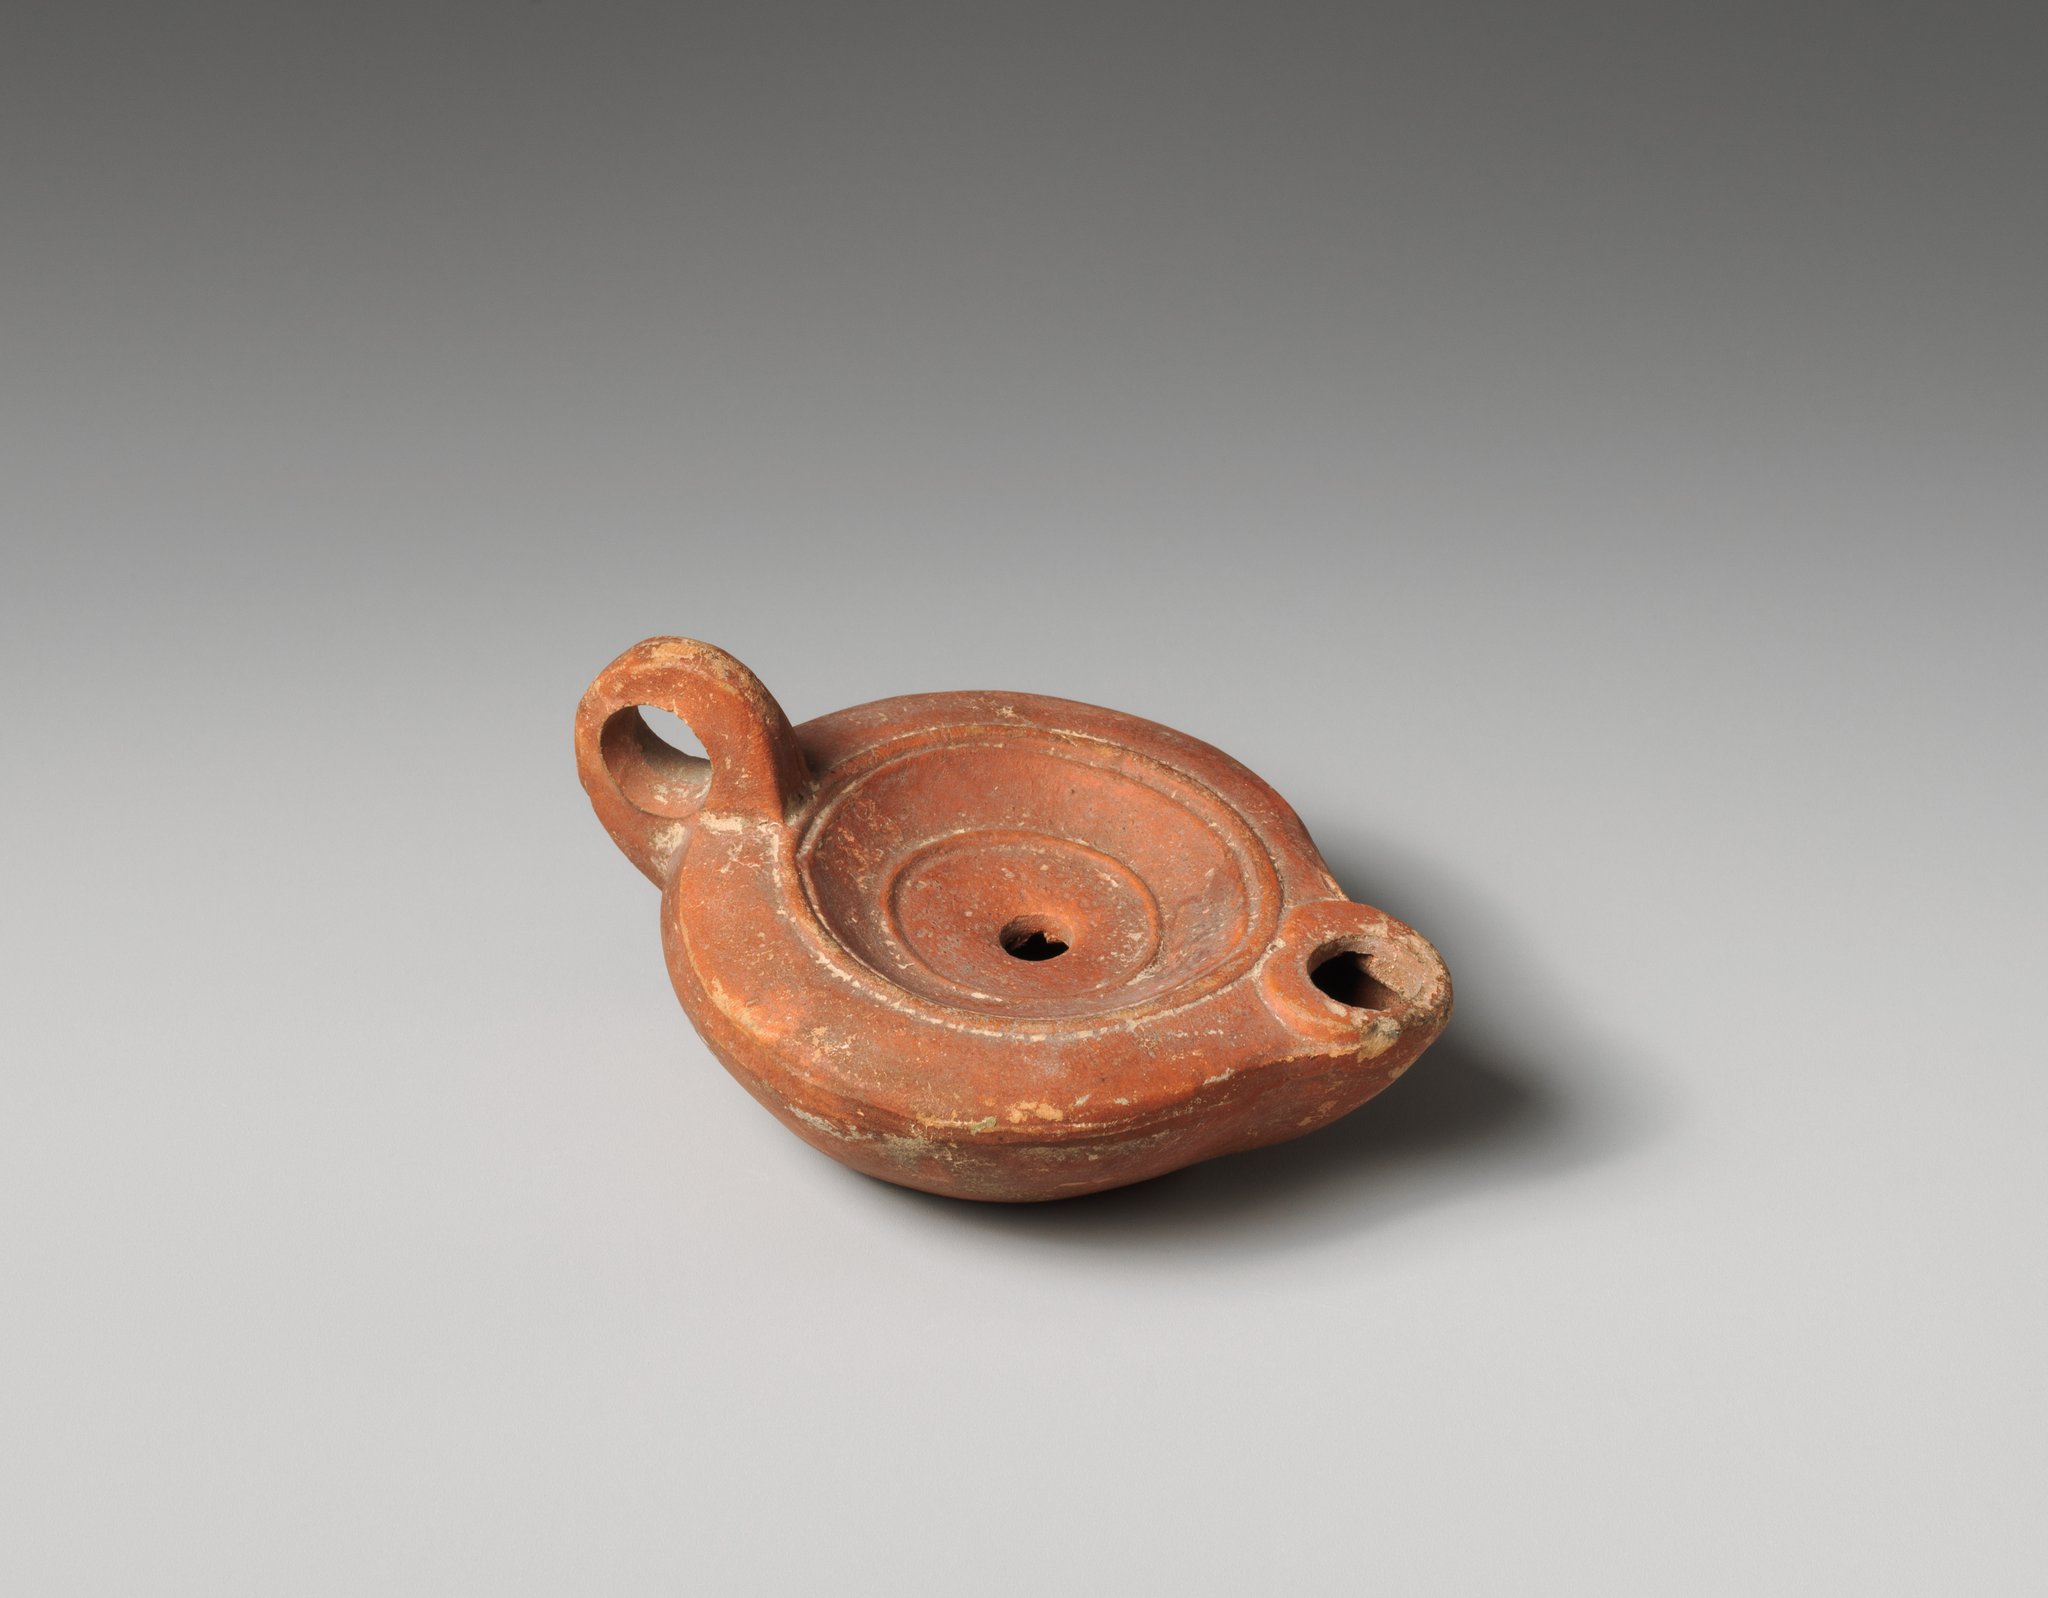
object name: lamp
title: Terracotta oil lamp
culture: roman, cypriot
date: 50-400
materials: terracotta